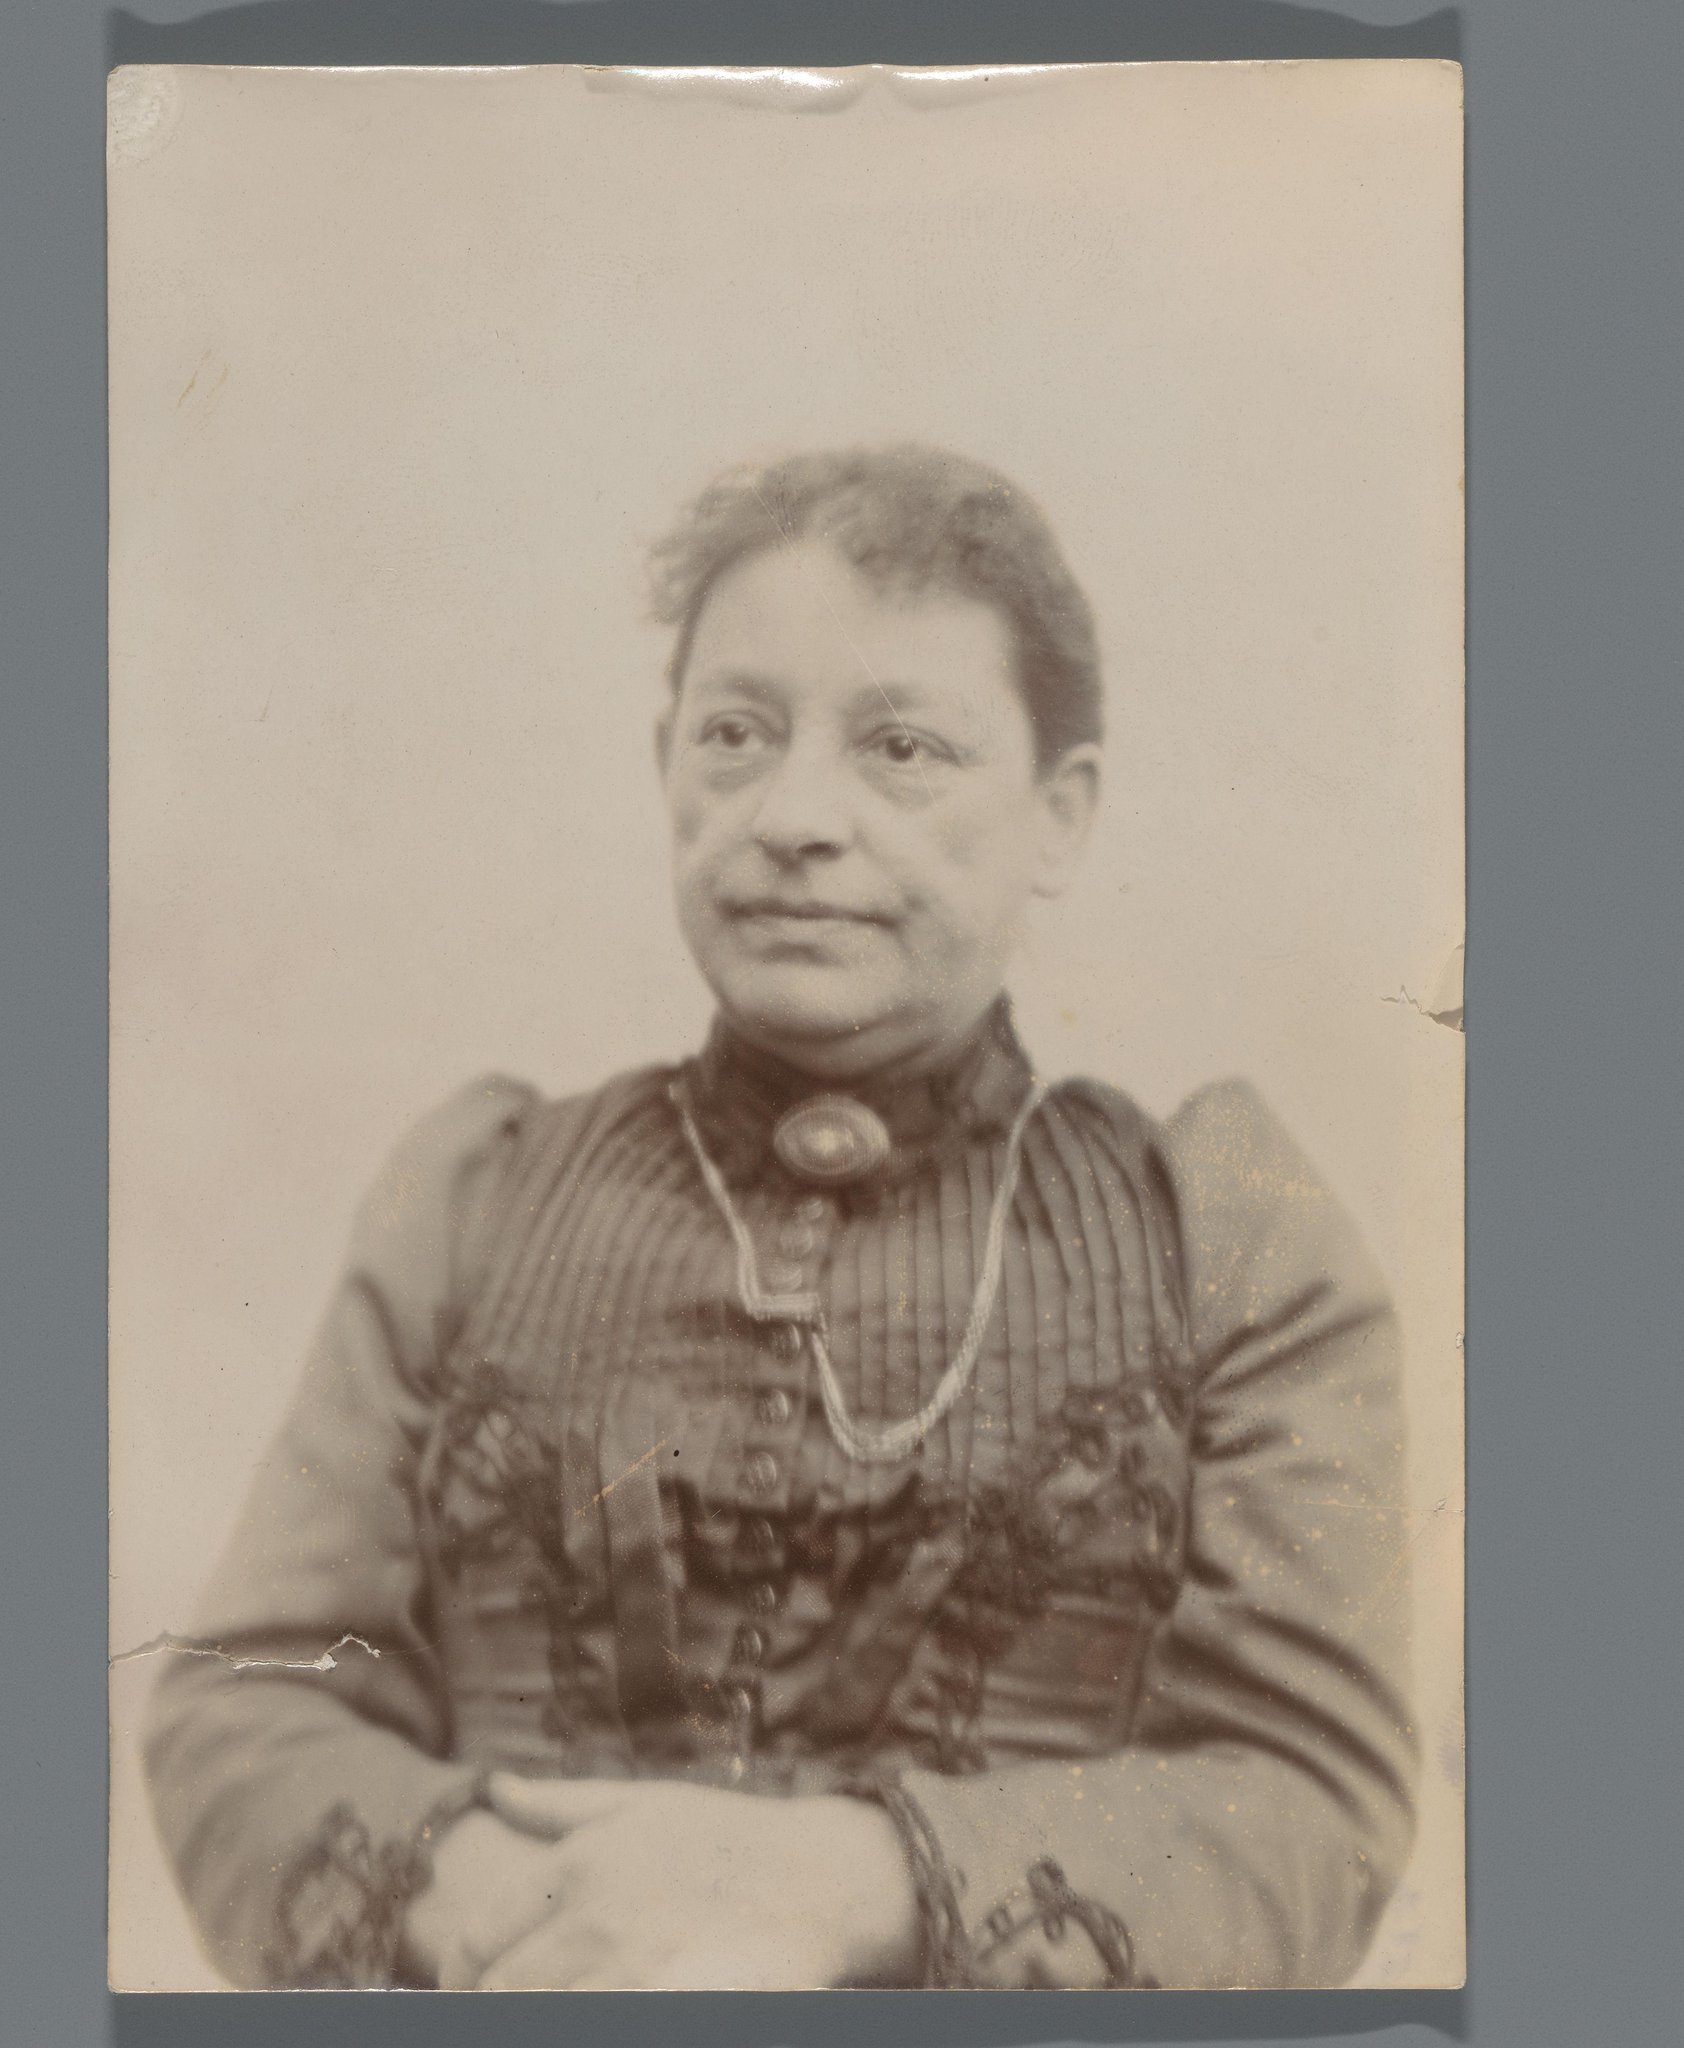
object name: photograph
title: Portret van een onbekende vrouw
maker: Anonymous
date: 1880-1910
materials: paper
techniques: collodion silver print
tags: anonymous historical person portrayed - bb - woman